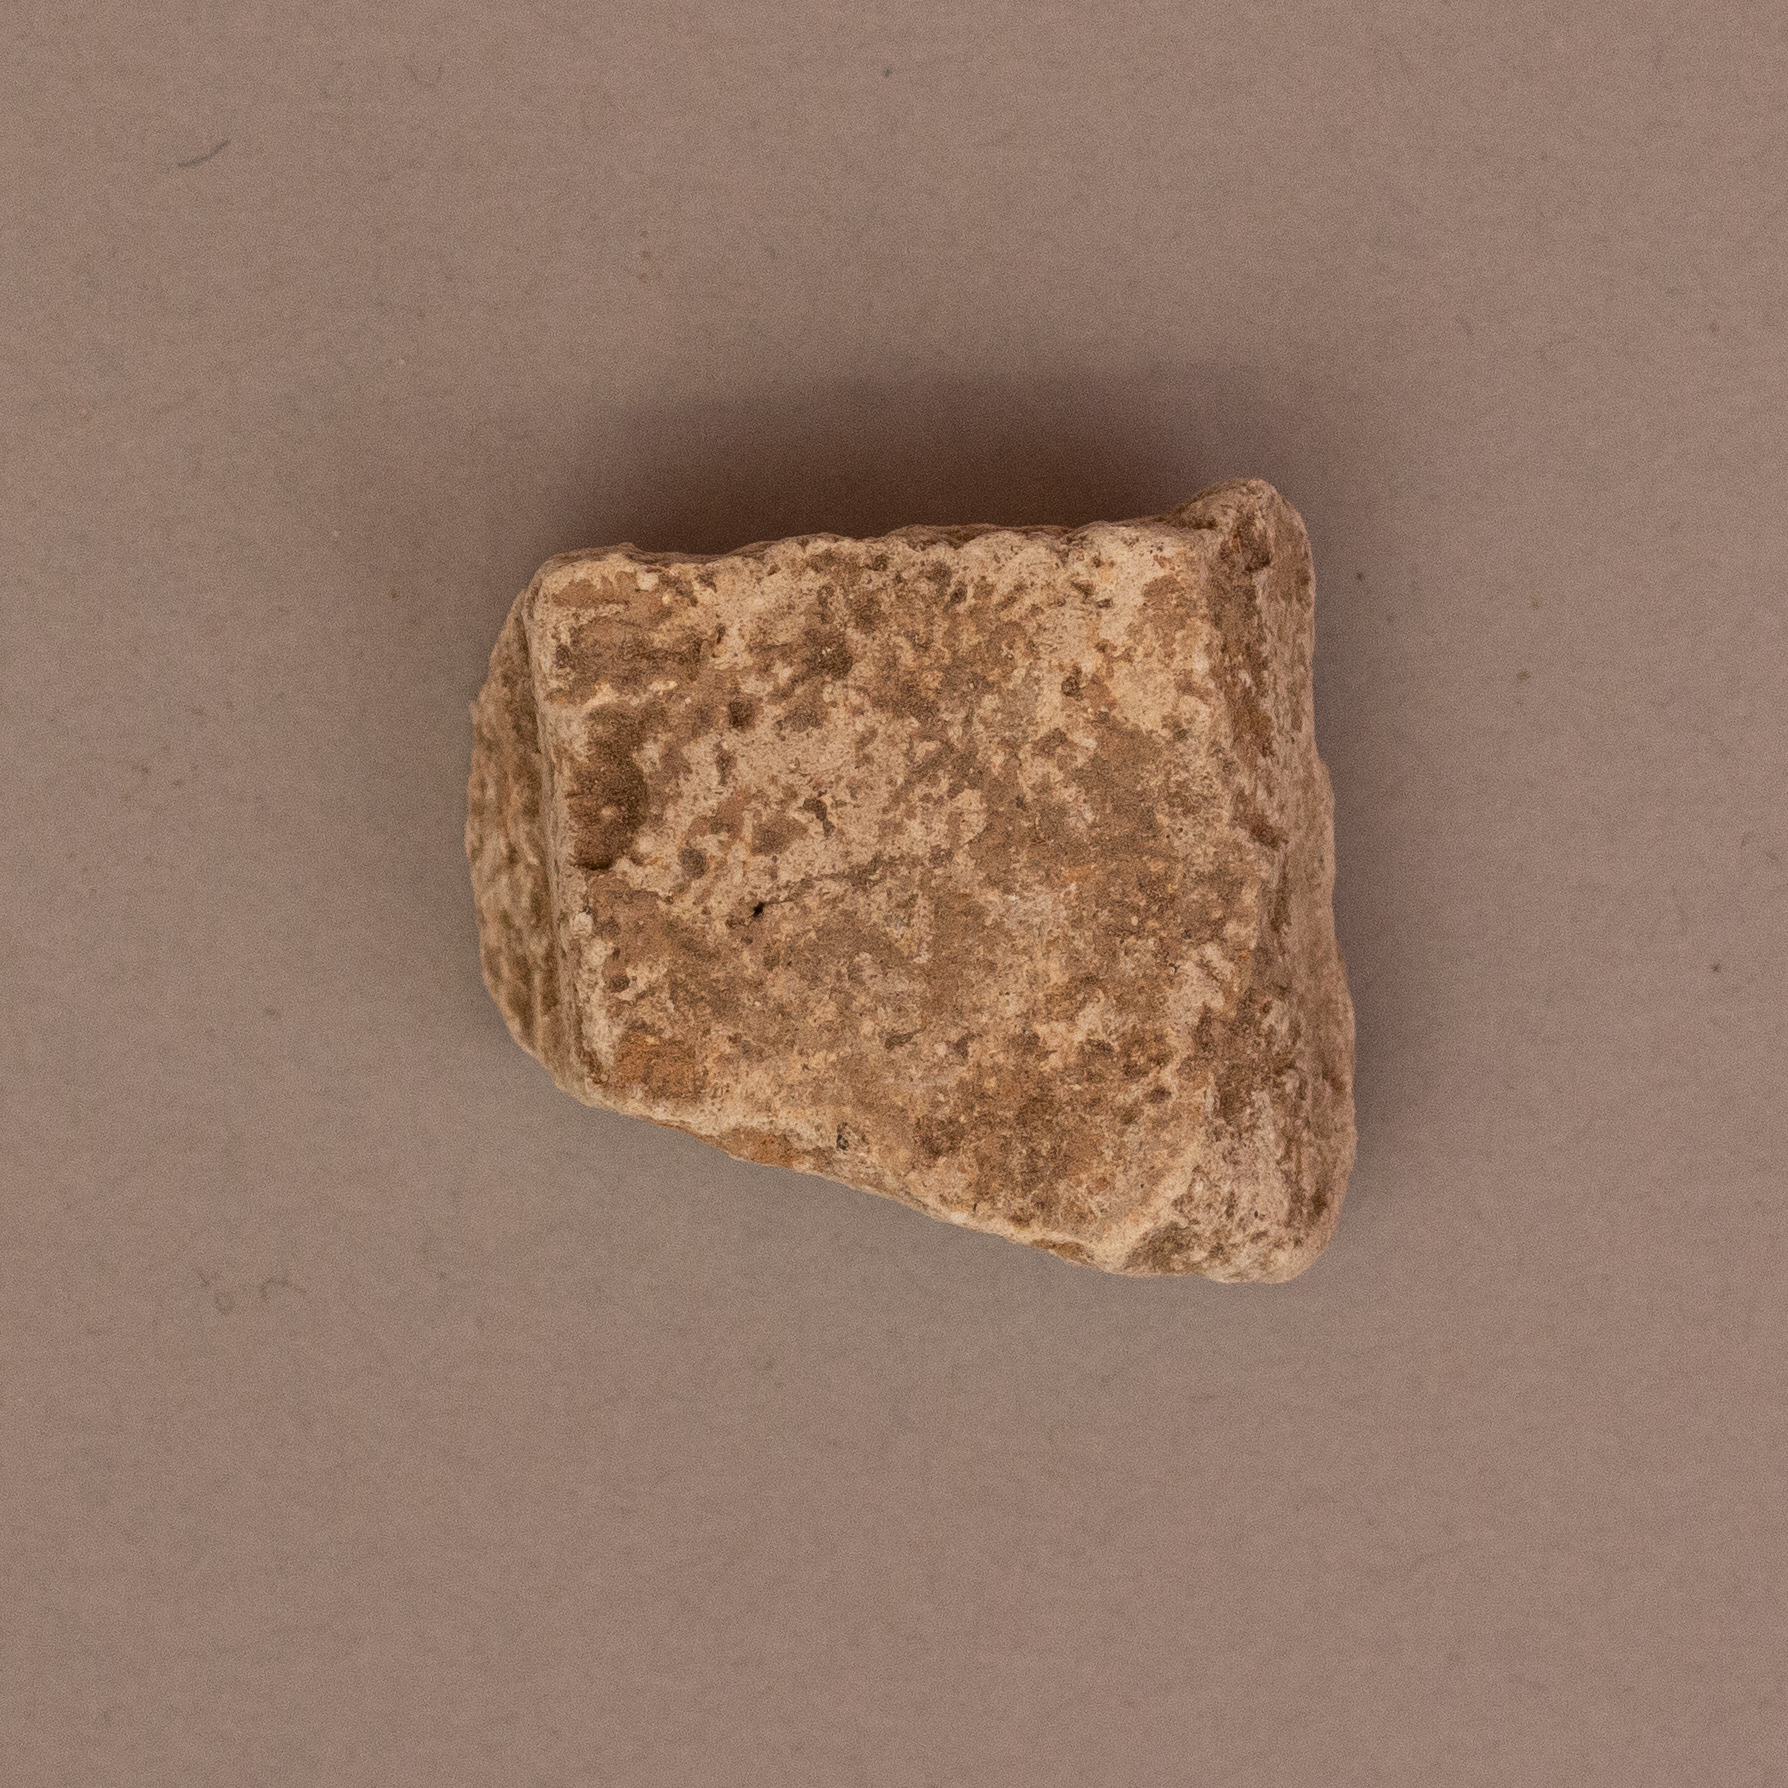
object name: fragment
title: Stucco Fragment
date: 701-1200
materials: plaster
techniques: carving, painting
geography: iran